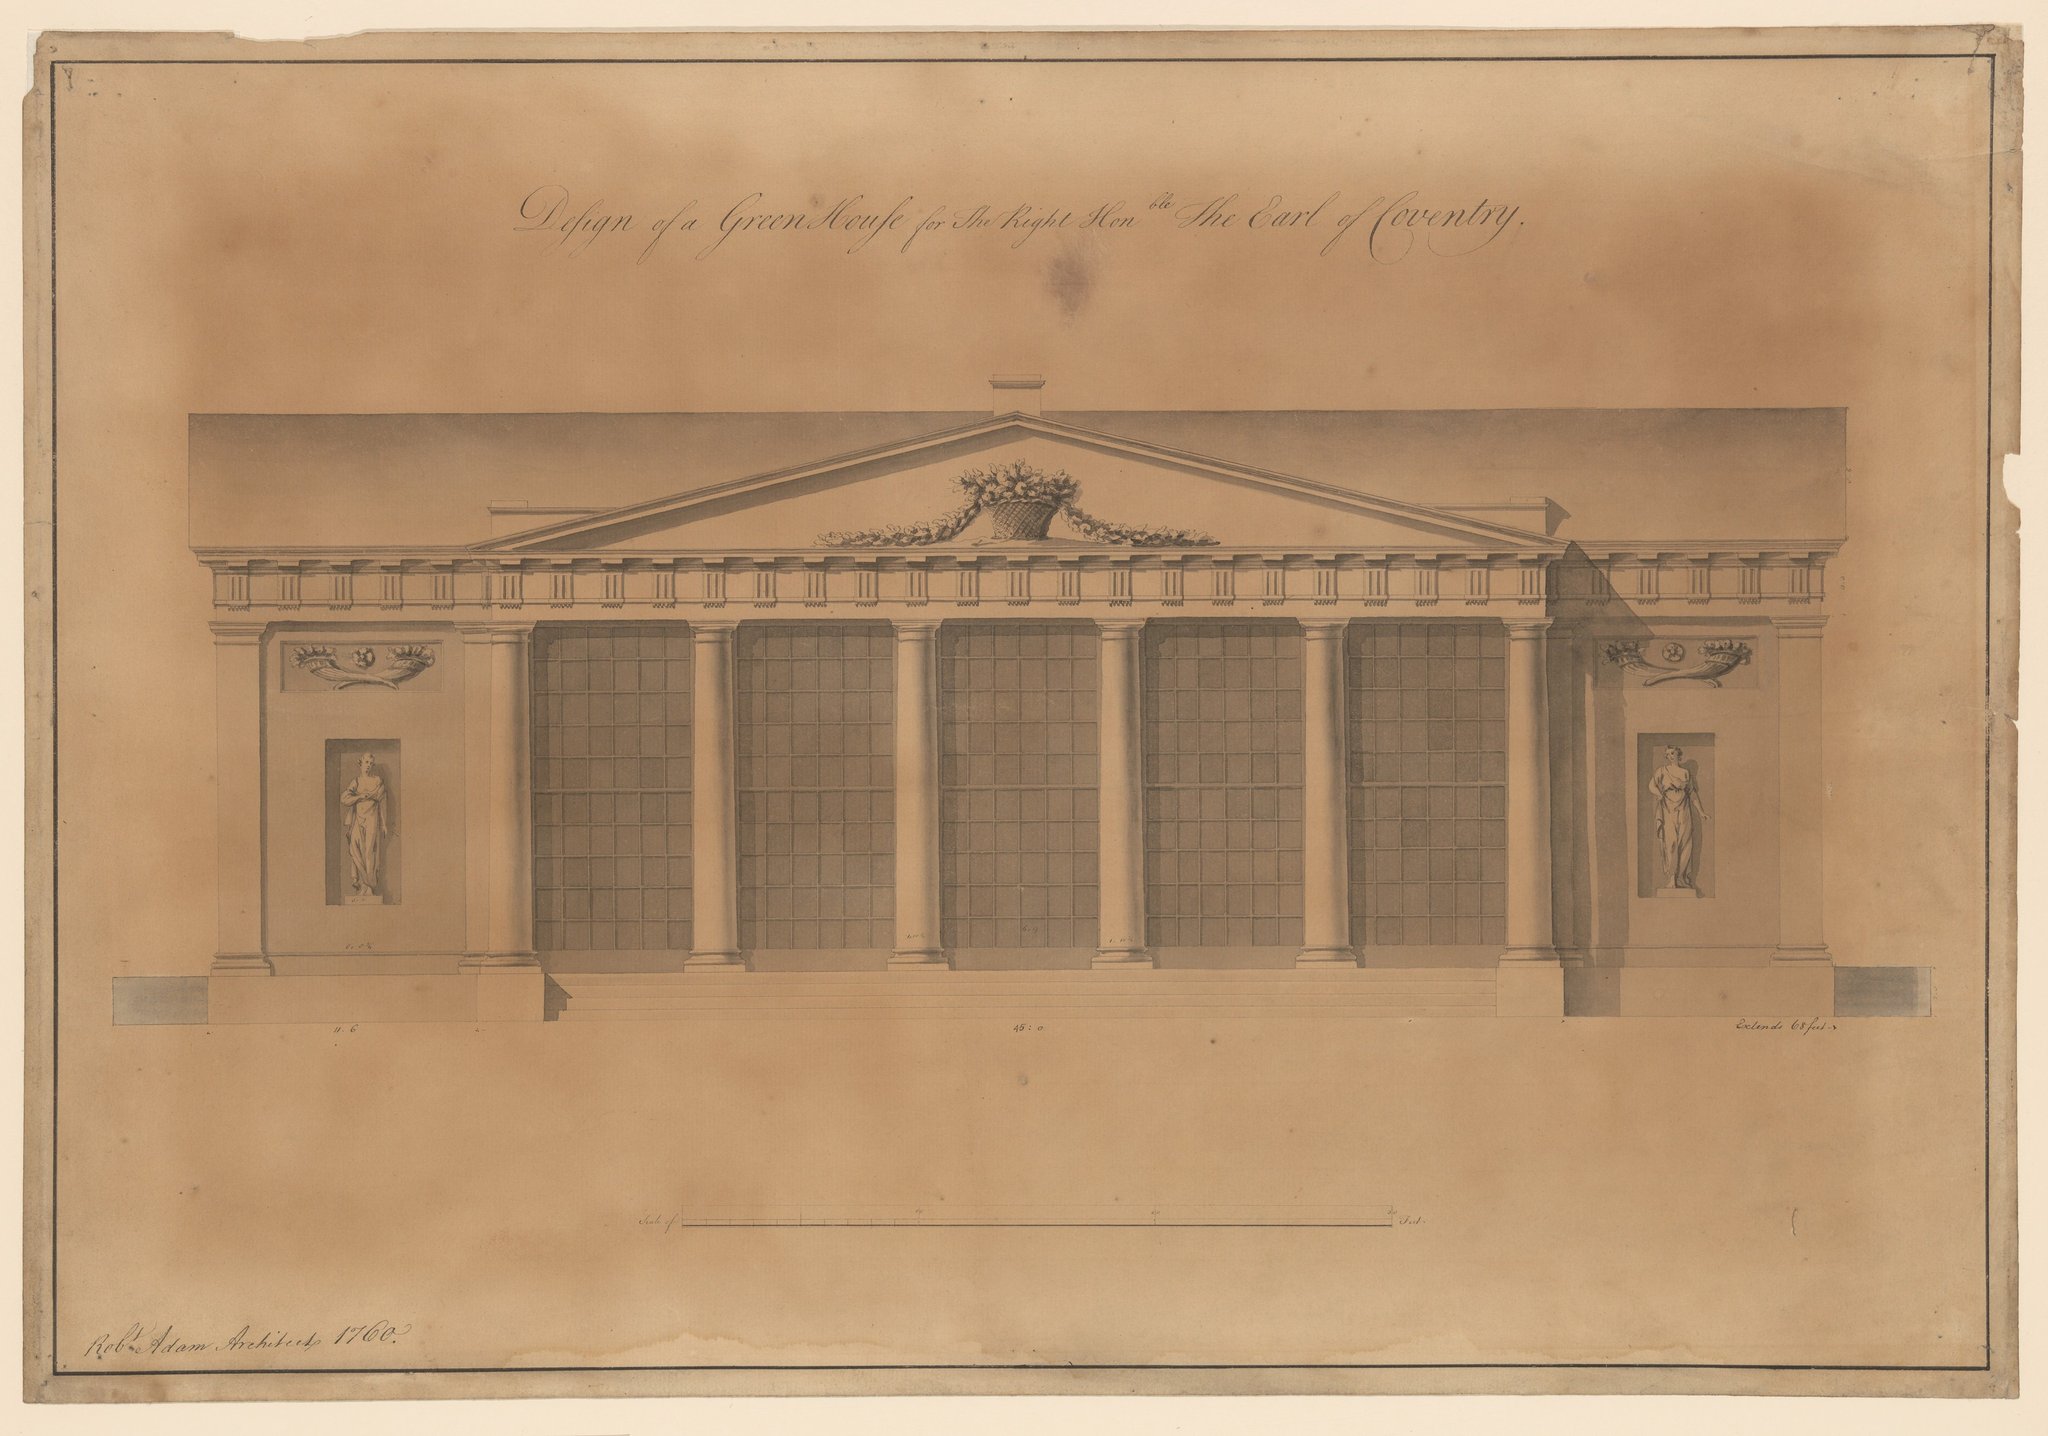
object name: drawing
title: Design of a Greenhouse for the Right Honorable Earl of Coventry, Croome Court, Worcestershire (Elevation)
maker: robert adam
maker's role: artist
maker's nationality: british, scottish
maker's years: 1728-1792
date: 1760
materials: ink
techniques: brush, pen, wash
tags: architecture,buildings